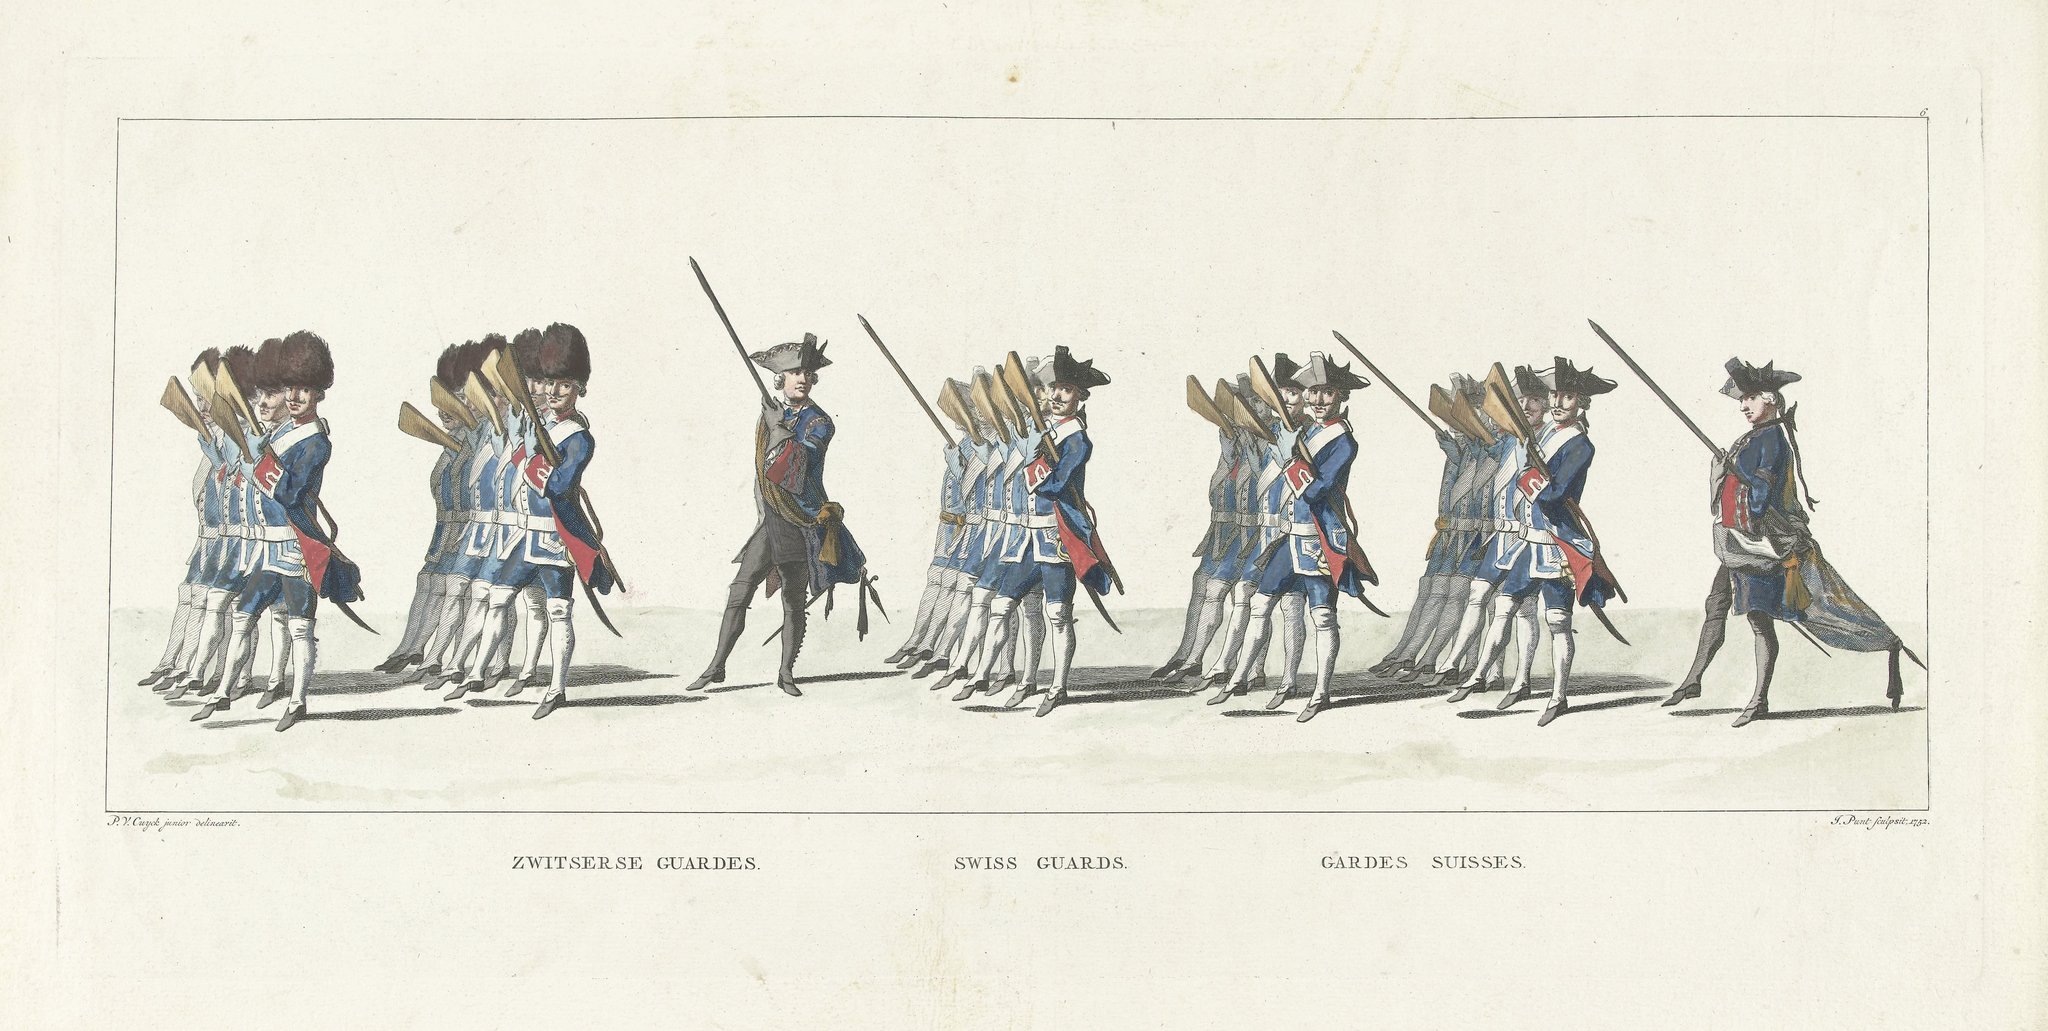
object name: print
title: Lyk-staetsie van zyne doorluchtigste Hoogheid den Heere Willem [IV] Carel Hendrik Friso, Prince van Orange en Nassau (...) gehouden den IV Februari 1752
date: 1752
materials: paper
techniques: engraving, etching, hand coloring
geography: northern netherlands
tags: the hague, willem iv (prins van oranje-nassau), military parade, pageant (+ infantry), cortege, funeral procession, delft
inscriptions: collector's mark: Lugt 2228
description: De Zwitserse Garde. In de marge het onderschrift in Nederlands, Frans en Duits. Onderdeel van een serie van 41 platen van de begrafenisstoet van stadhouder Willem IV te Delft op 4 februari 1752. Genummerd rechtsboven: 6.